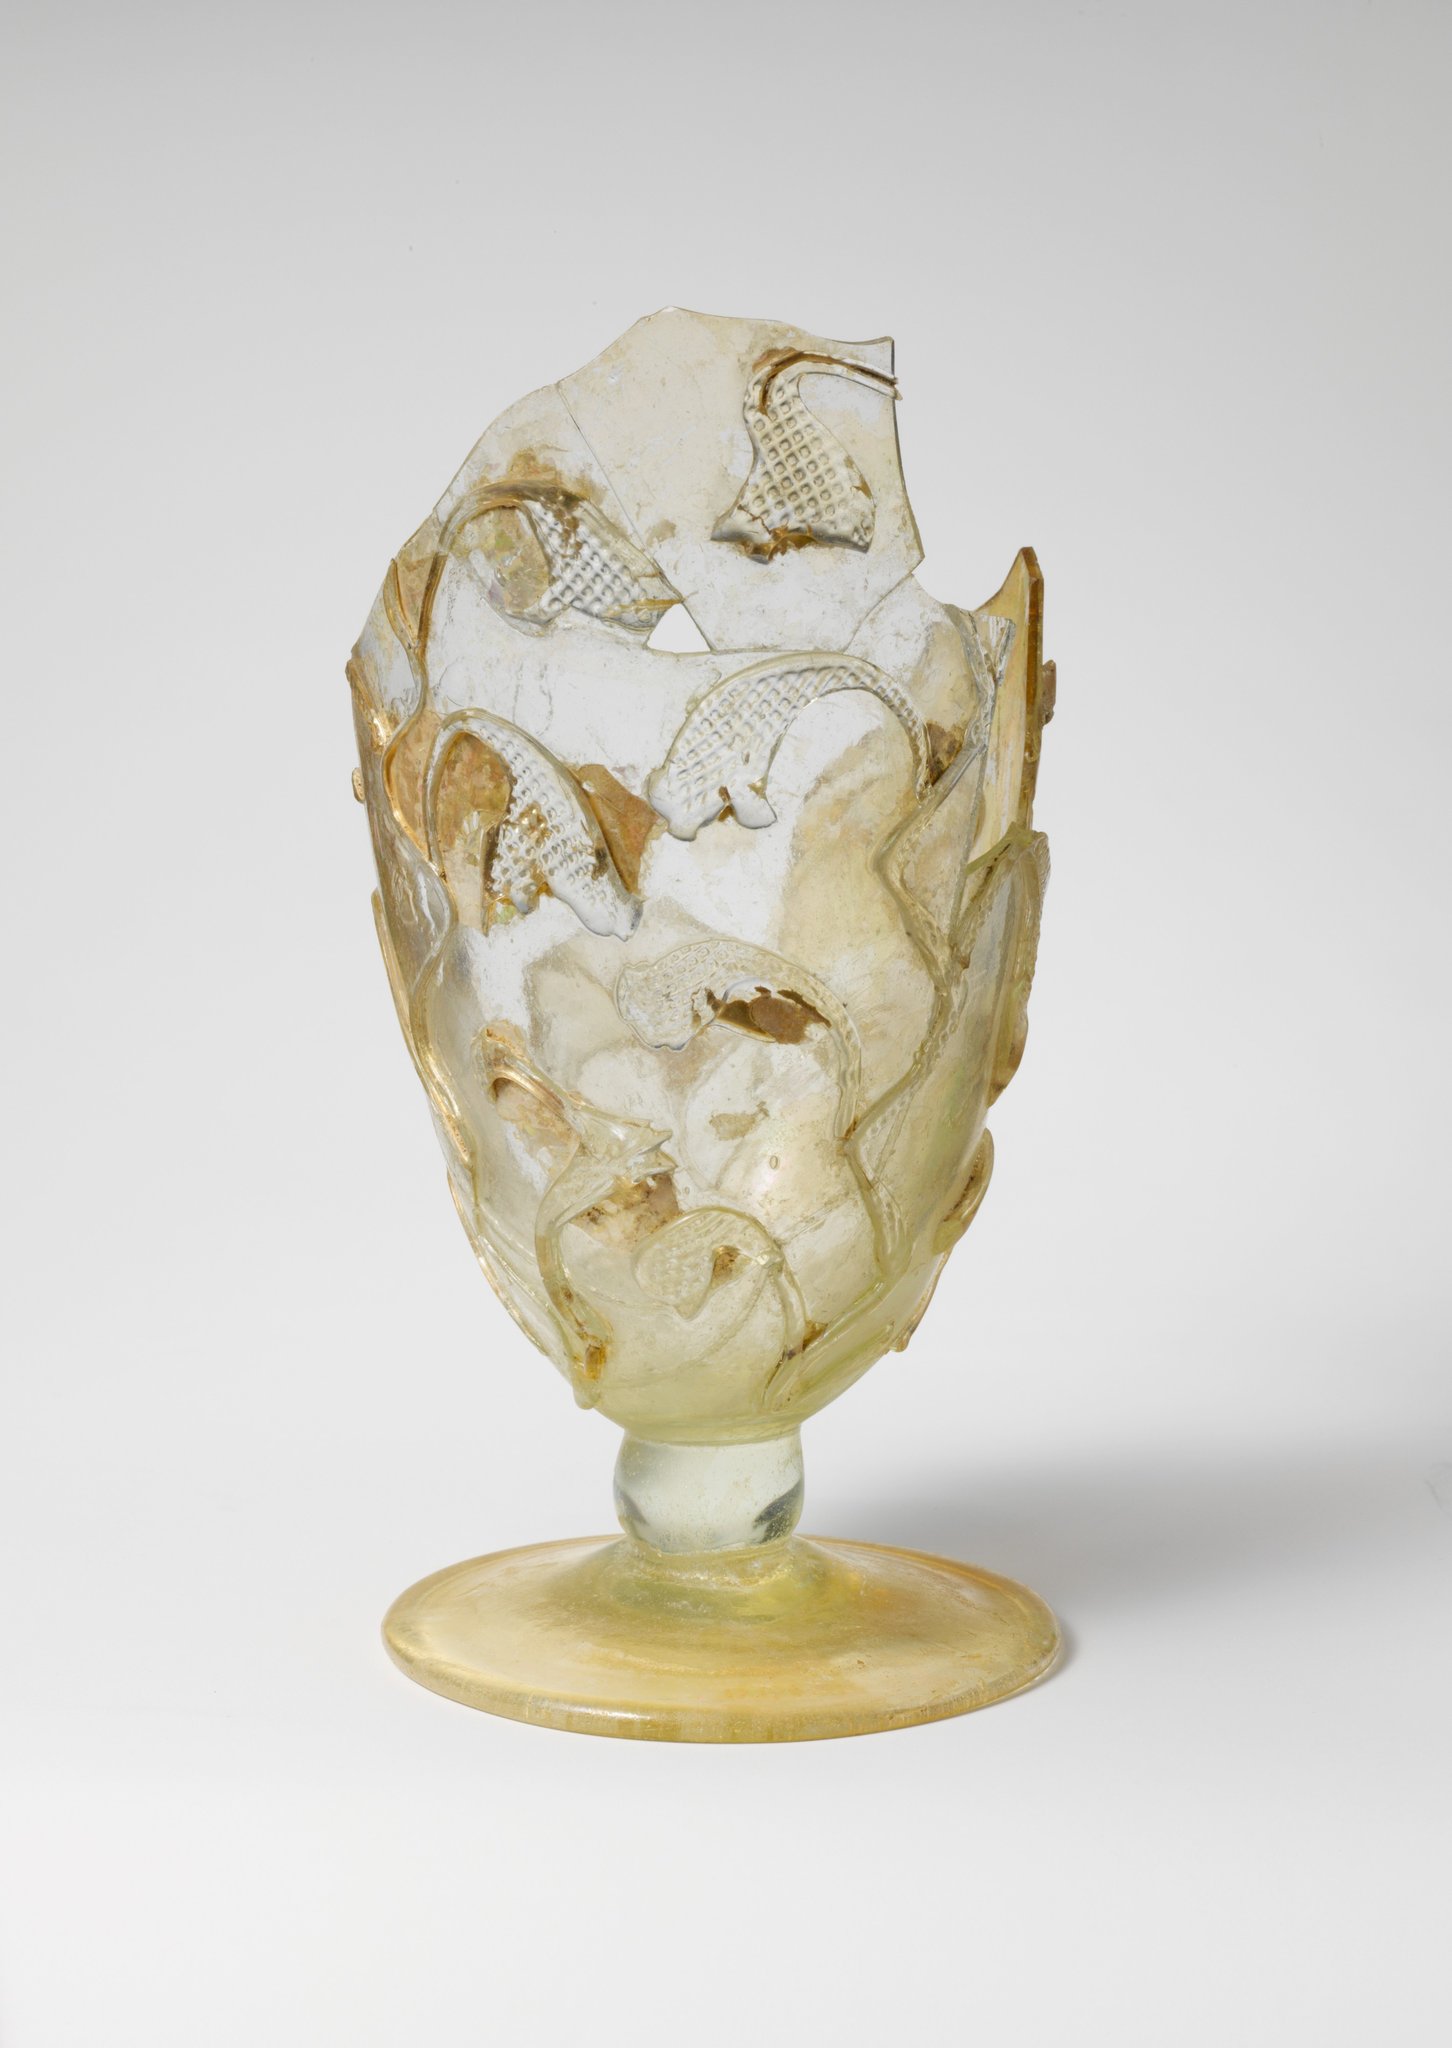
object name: beaker, fragmentary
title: Glass beaker with snake-thread decoration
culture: roman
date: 201-300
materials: glass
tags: snakes